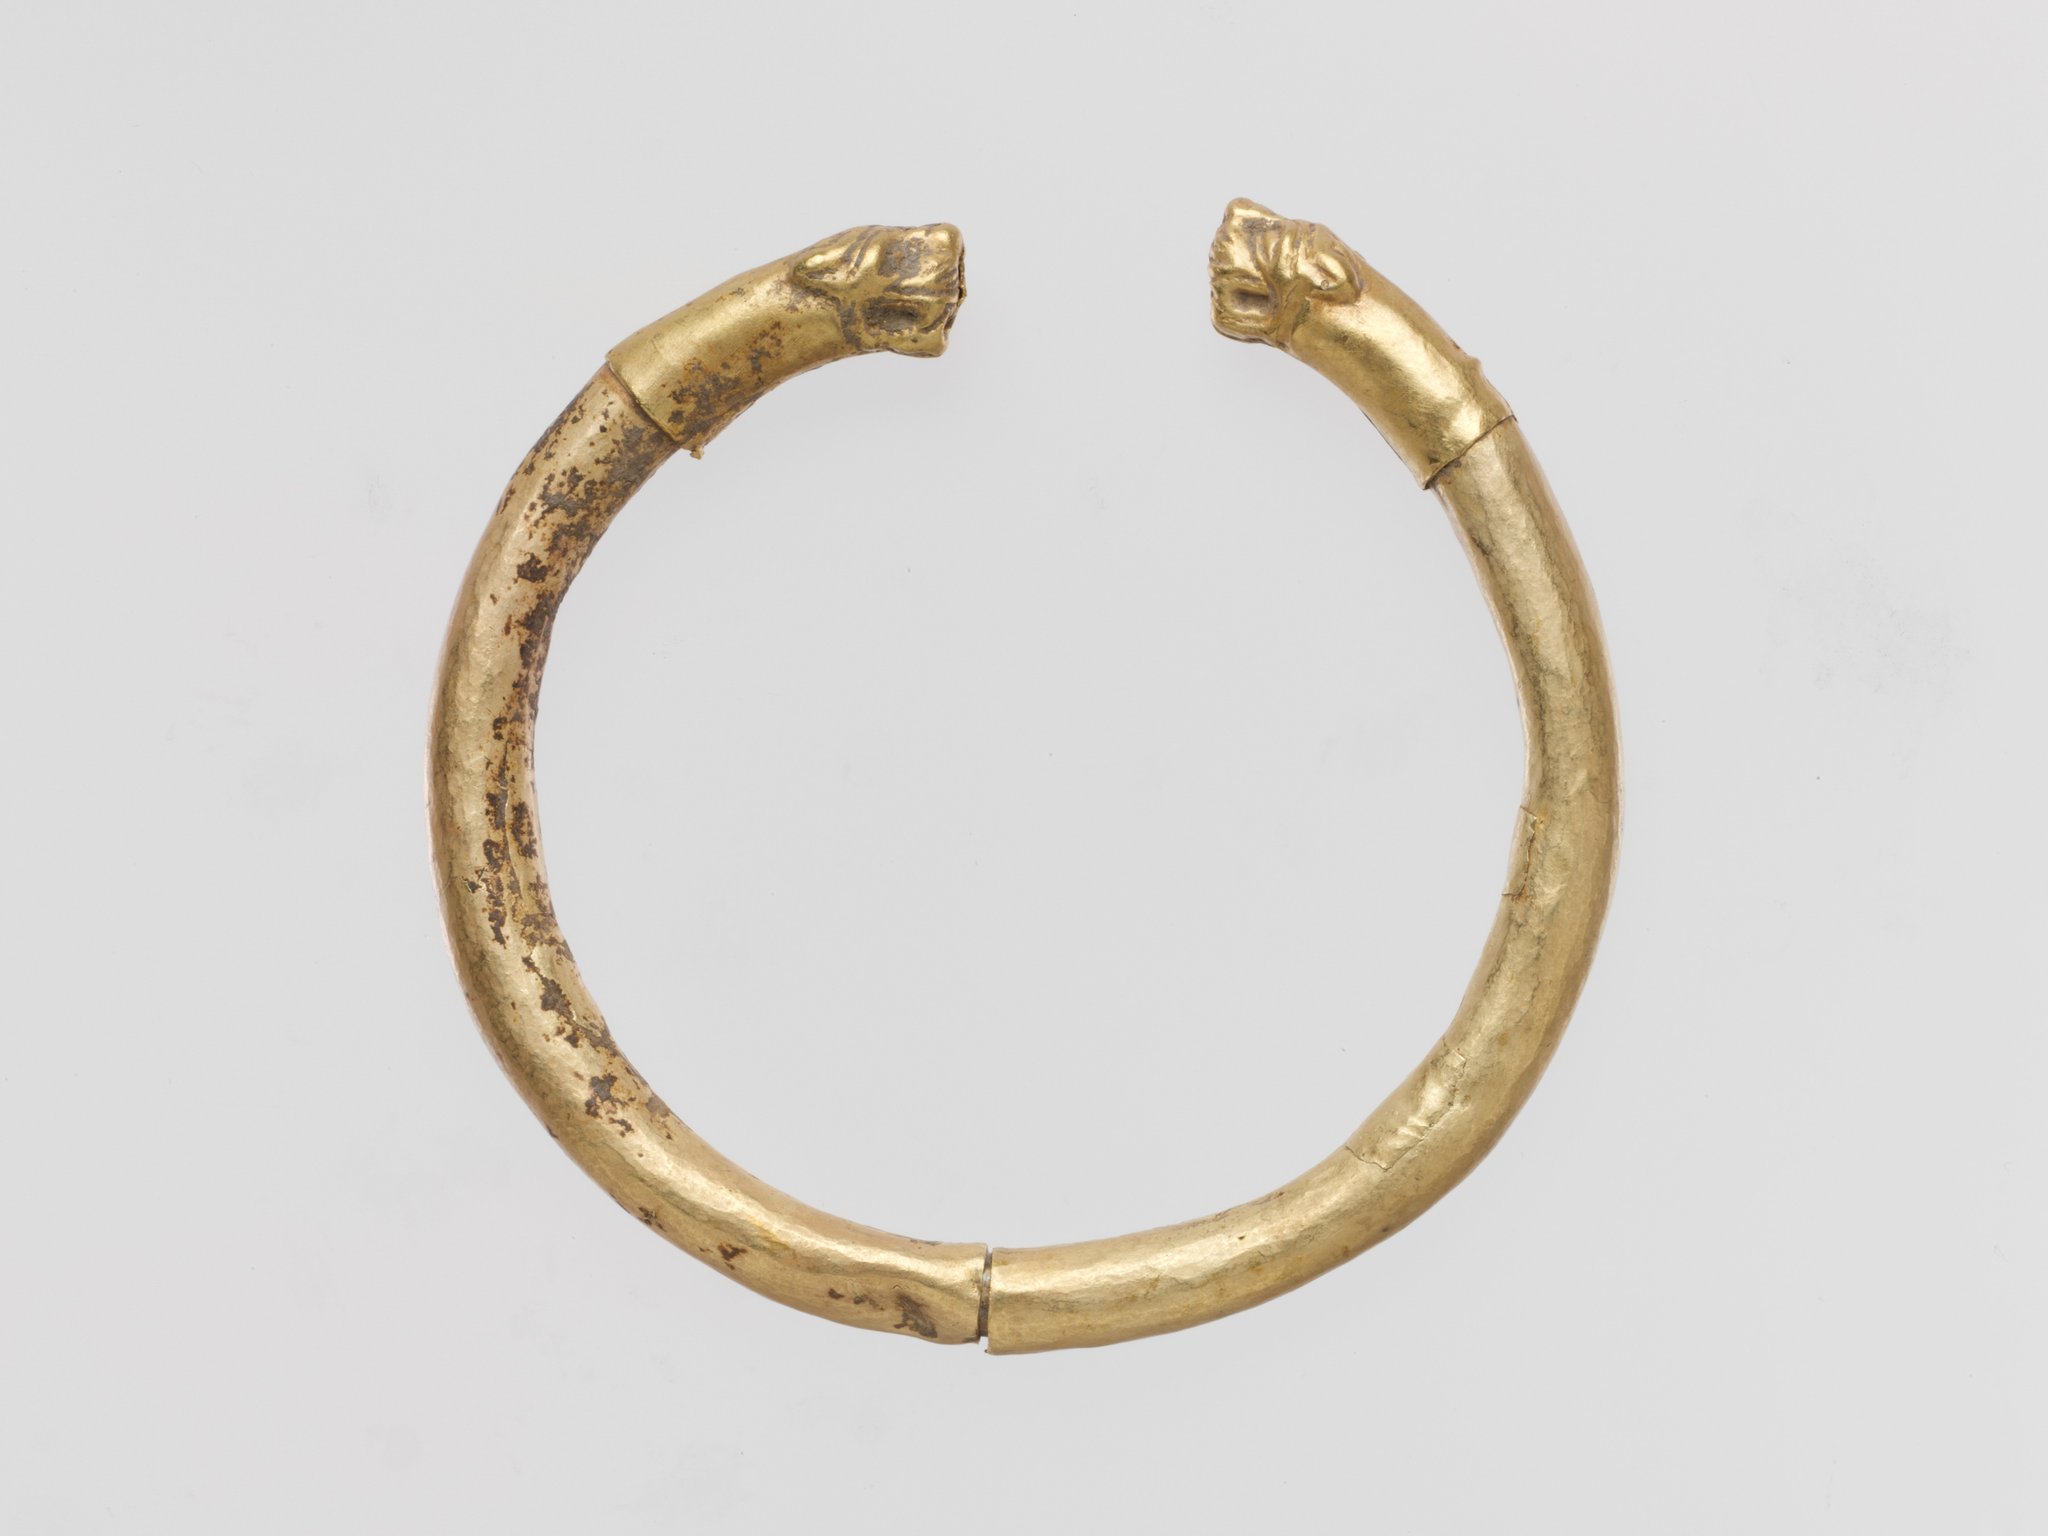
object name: bracelet with feline head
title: Gold bracelet with finials in the form of feline heads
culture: east greek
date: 634-601 BCE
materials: gold